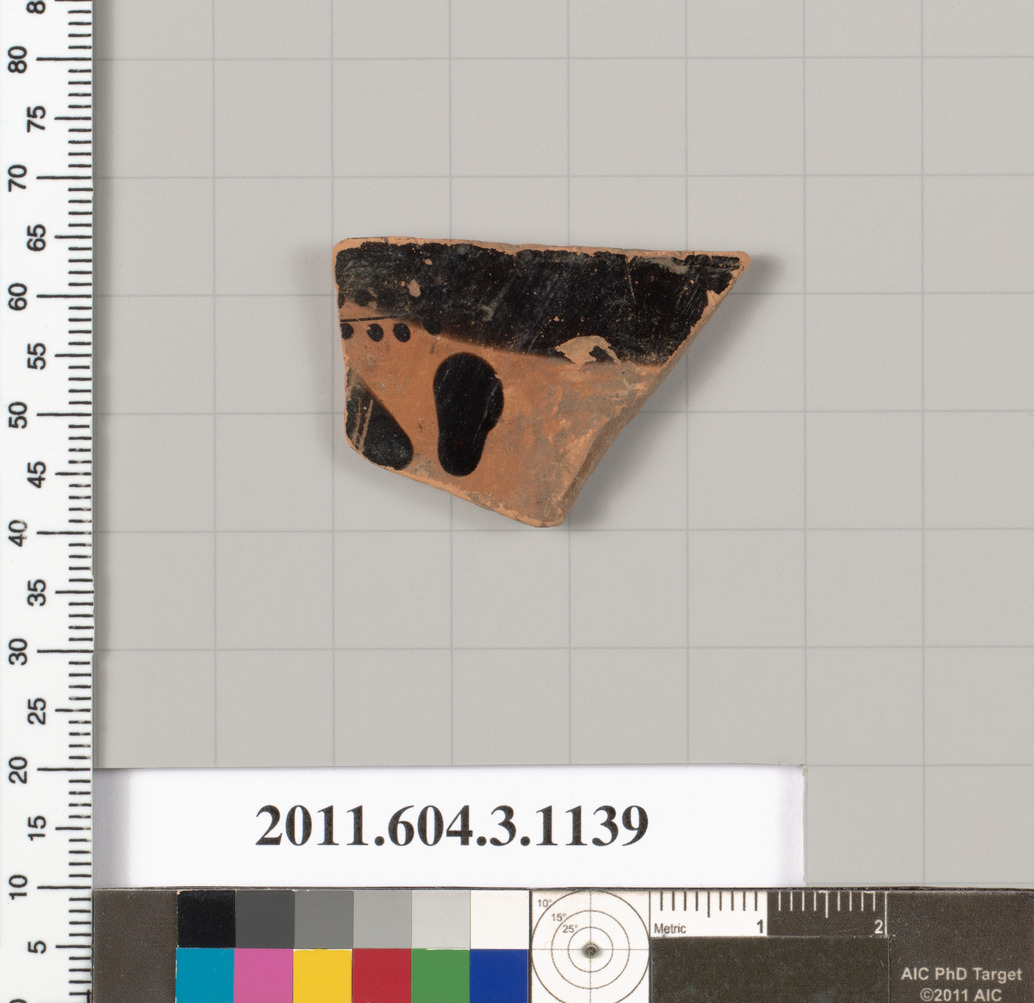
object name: mastoid or kyathos fragment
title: Terracotta fragment of a mastoid (drinking cup with narrow base) or a kyathos (cup-shaped ladle)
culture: greek, attic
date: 534-468 BCE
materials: terracotta